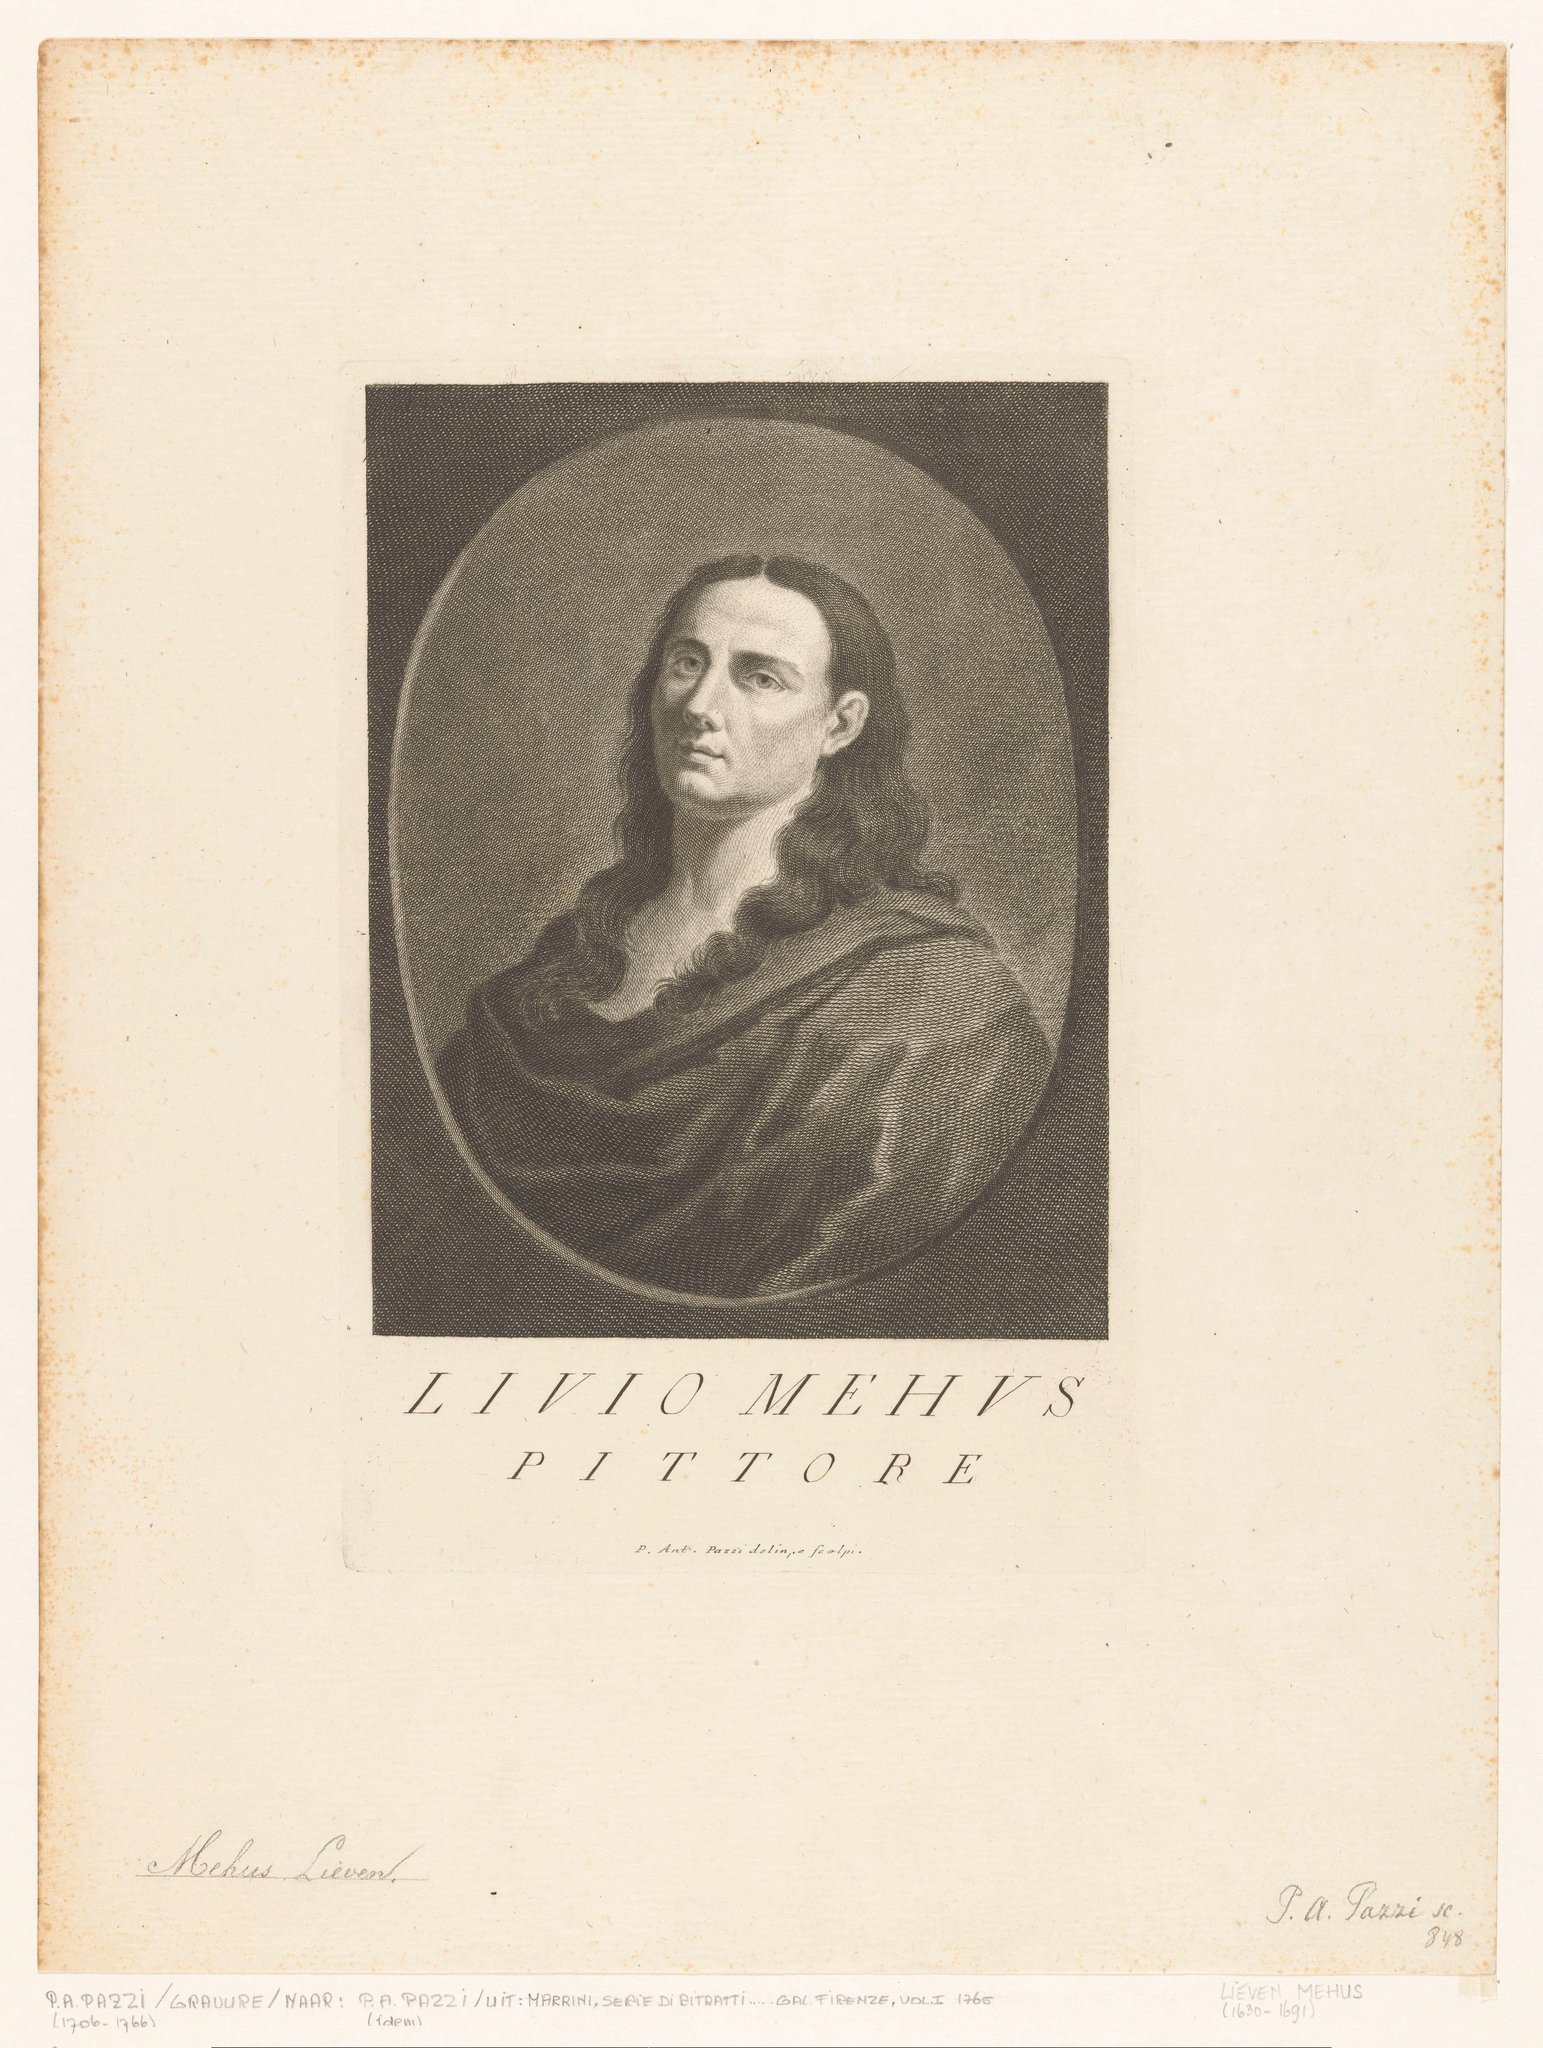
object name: print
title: Portretten van kunstenaars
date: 1752-1762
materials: paper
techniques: engraving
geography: italy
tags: print maker, draughtsman, lieven mehus, historical persons, portrait, self-portrait of artist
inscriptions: collector's mark: ‘RIJKS / MUSM’, collector's mark: Lugt 2760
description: Prent mogelijk naar een zelfportret van Lieven Mehus. Prent uit: Moücke, Francesco. Serie di ritratti degli eccellenti pittori dipinti di propria mano, che esistono nell'Imiperial Galleria di Firenze. Florence: 1752-1762, dl. I.